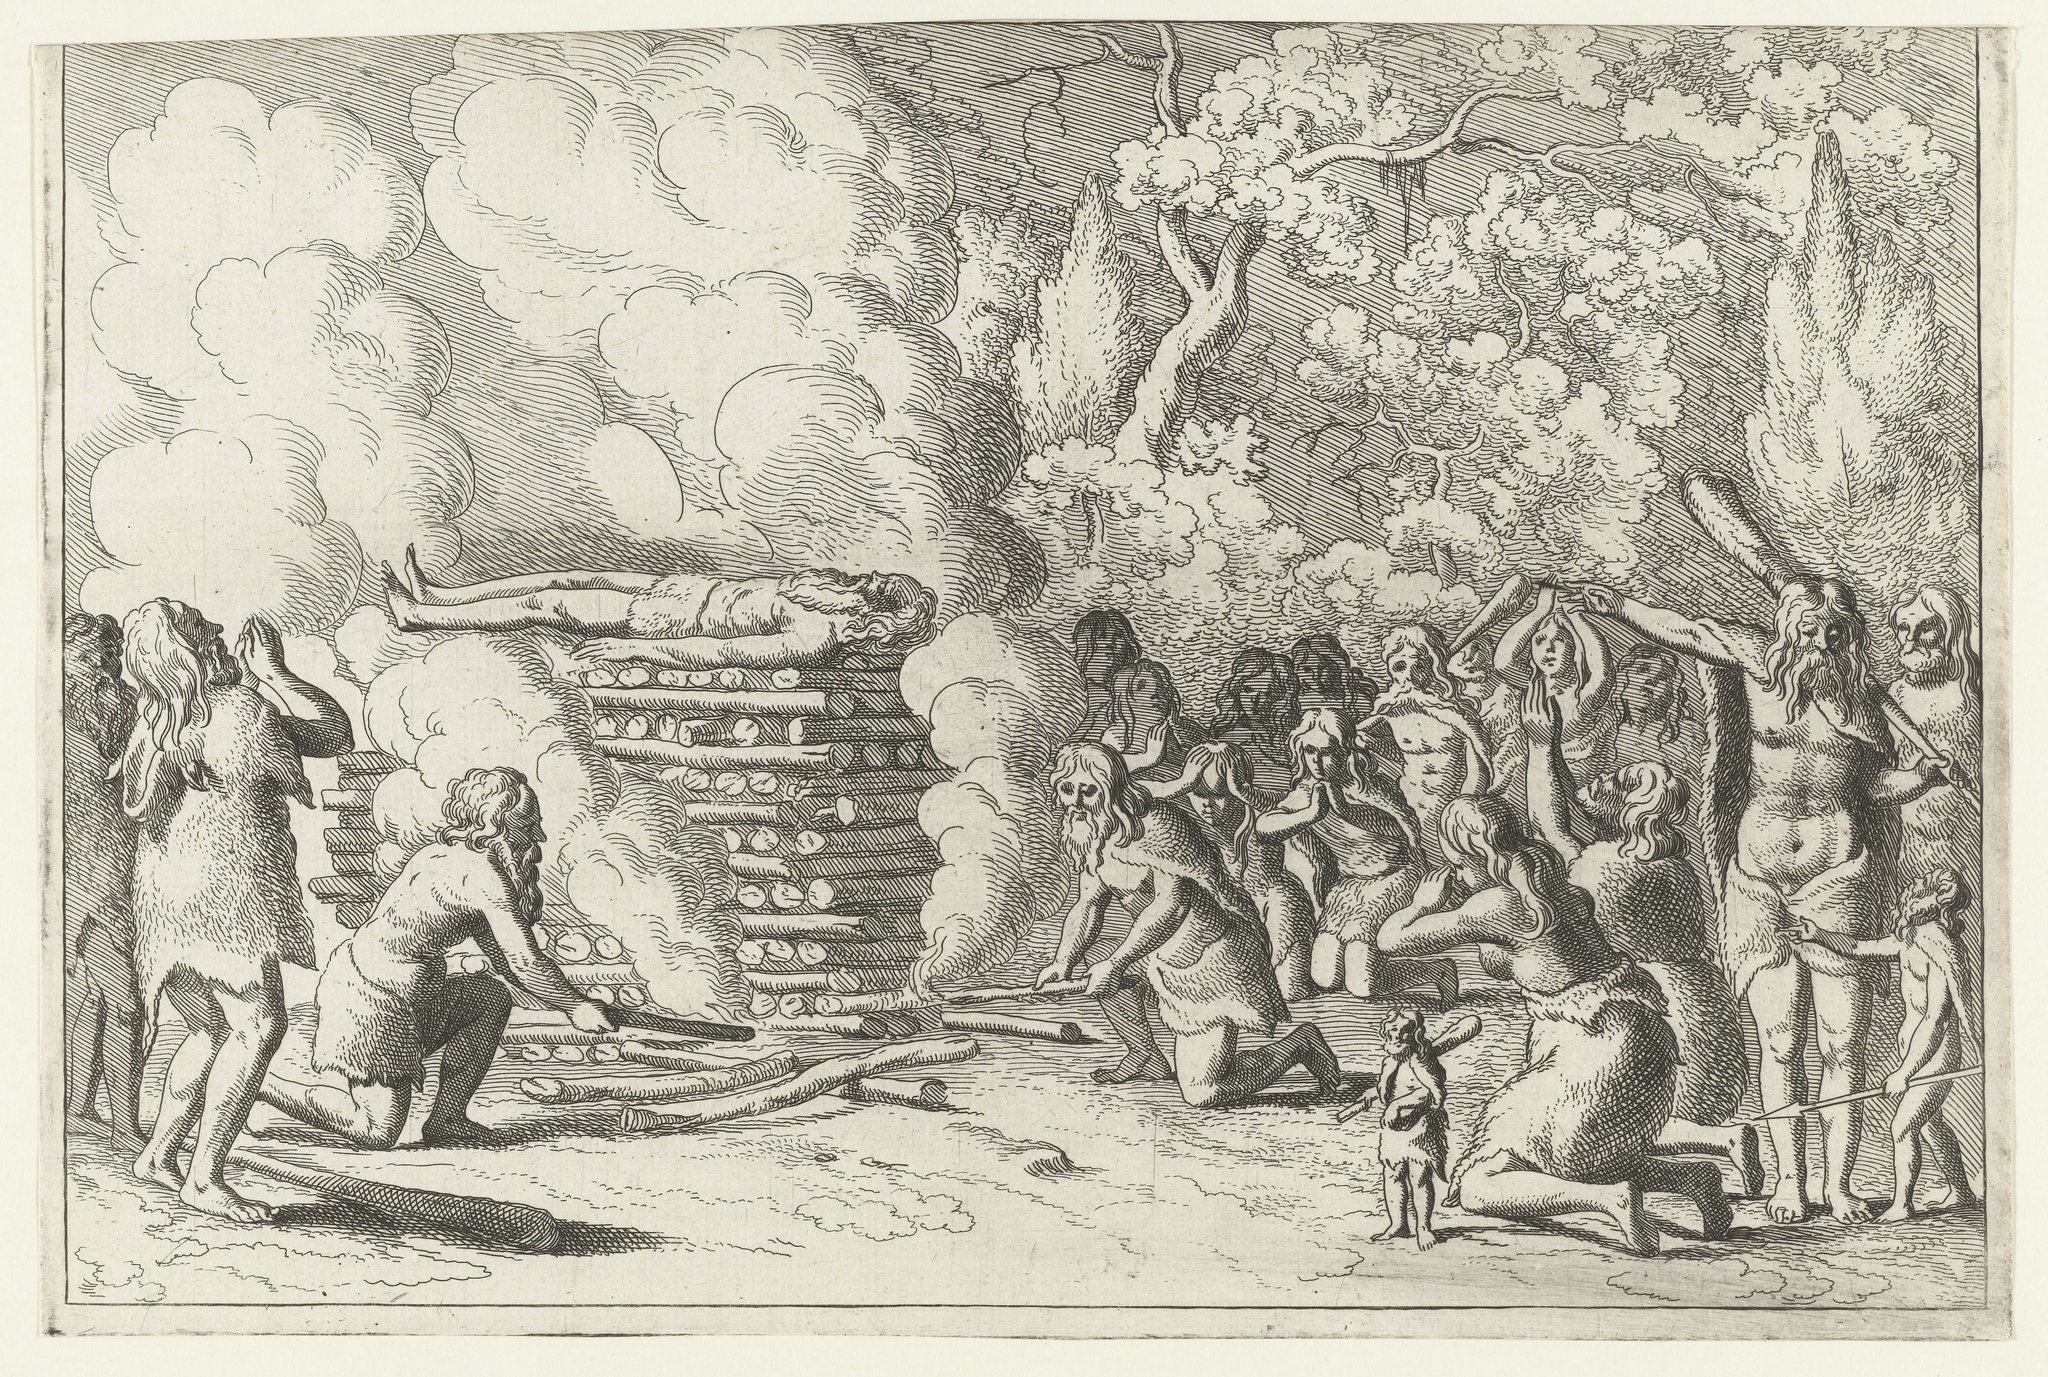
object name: print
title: Crematie op een brandstapel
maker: Anonymous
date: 1658-1660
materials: paper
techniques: etching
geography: netherlands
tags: body-burning, cremation, extinct, 'historical' peoples (with name), netherlands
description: Crematie op een brandstapel. Maakt deel uit van de acht illustraties in: Johan Picardt, Korte beschryvinge van eenige vergetene en verborgene antiquiteten … in het antiquiteet-rijcke landschap Drenth, Tymon Houthaak, Amsterdam 1660.